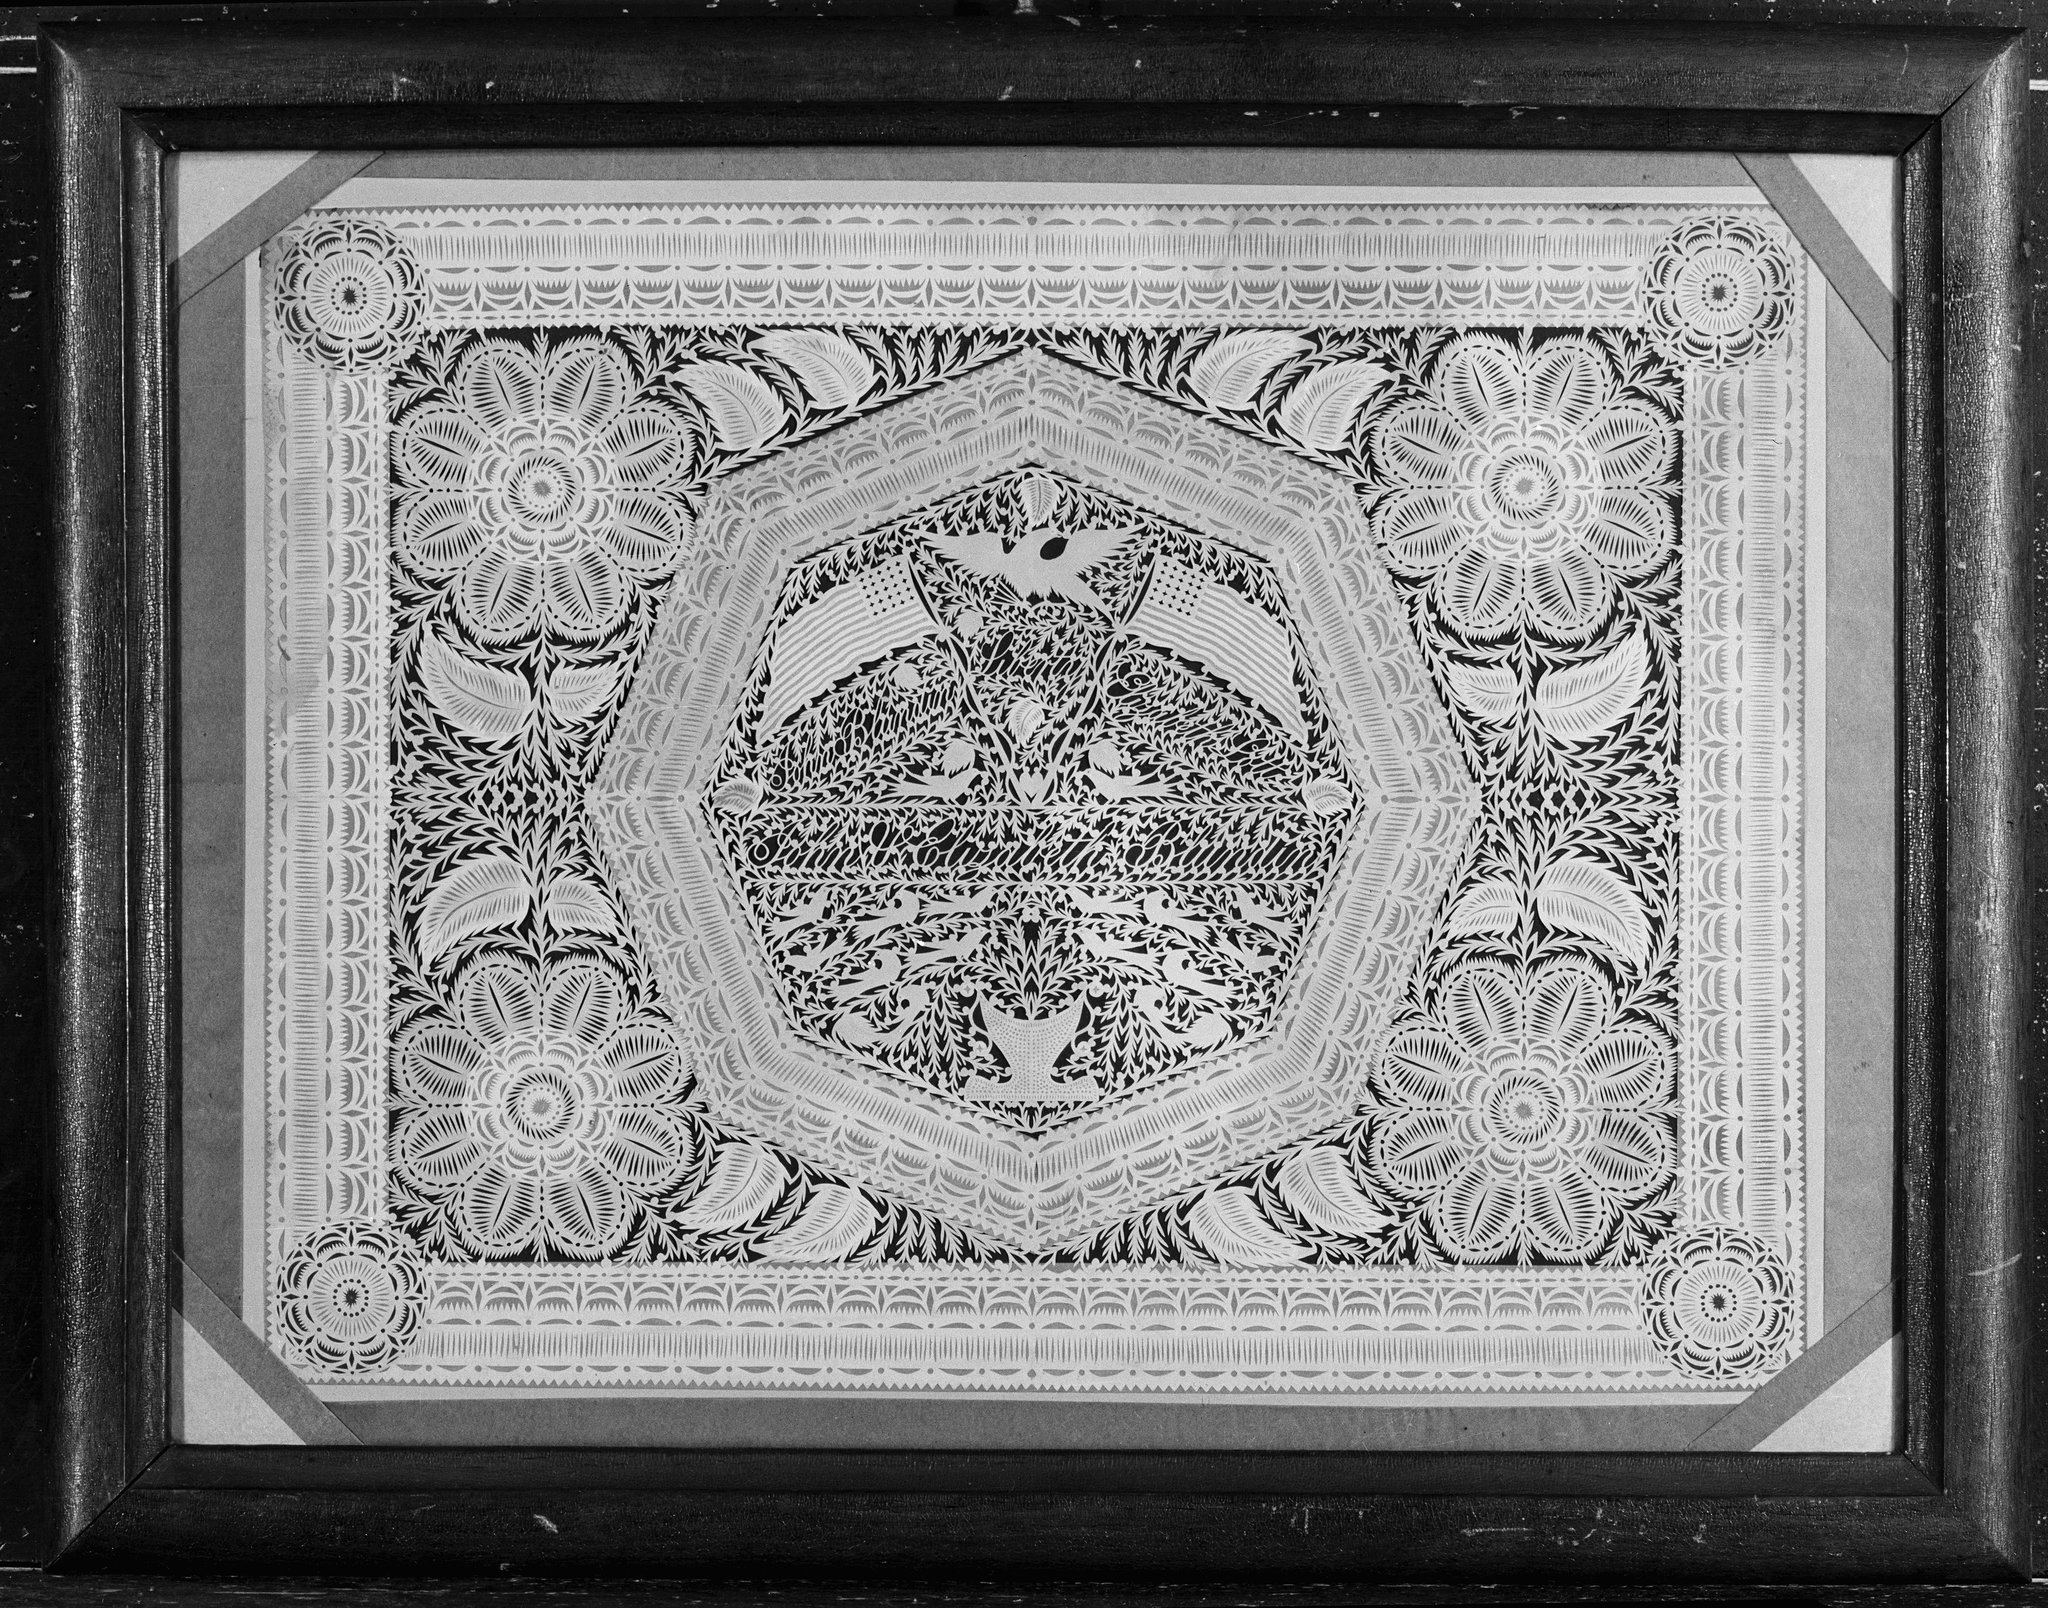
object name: marriage certificate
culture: american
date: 1825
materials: paper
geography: united states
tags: eagles,flowers